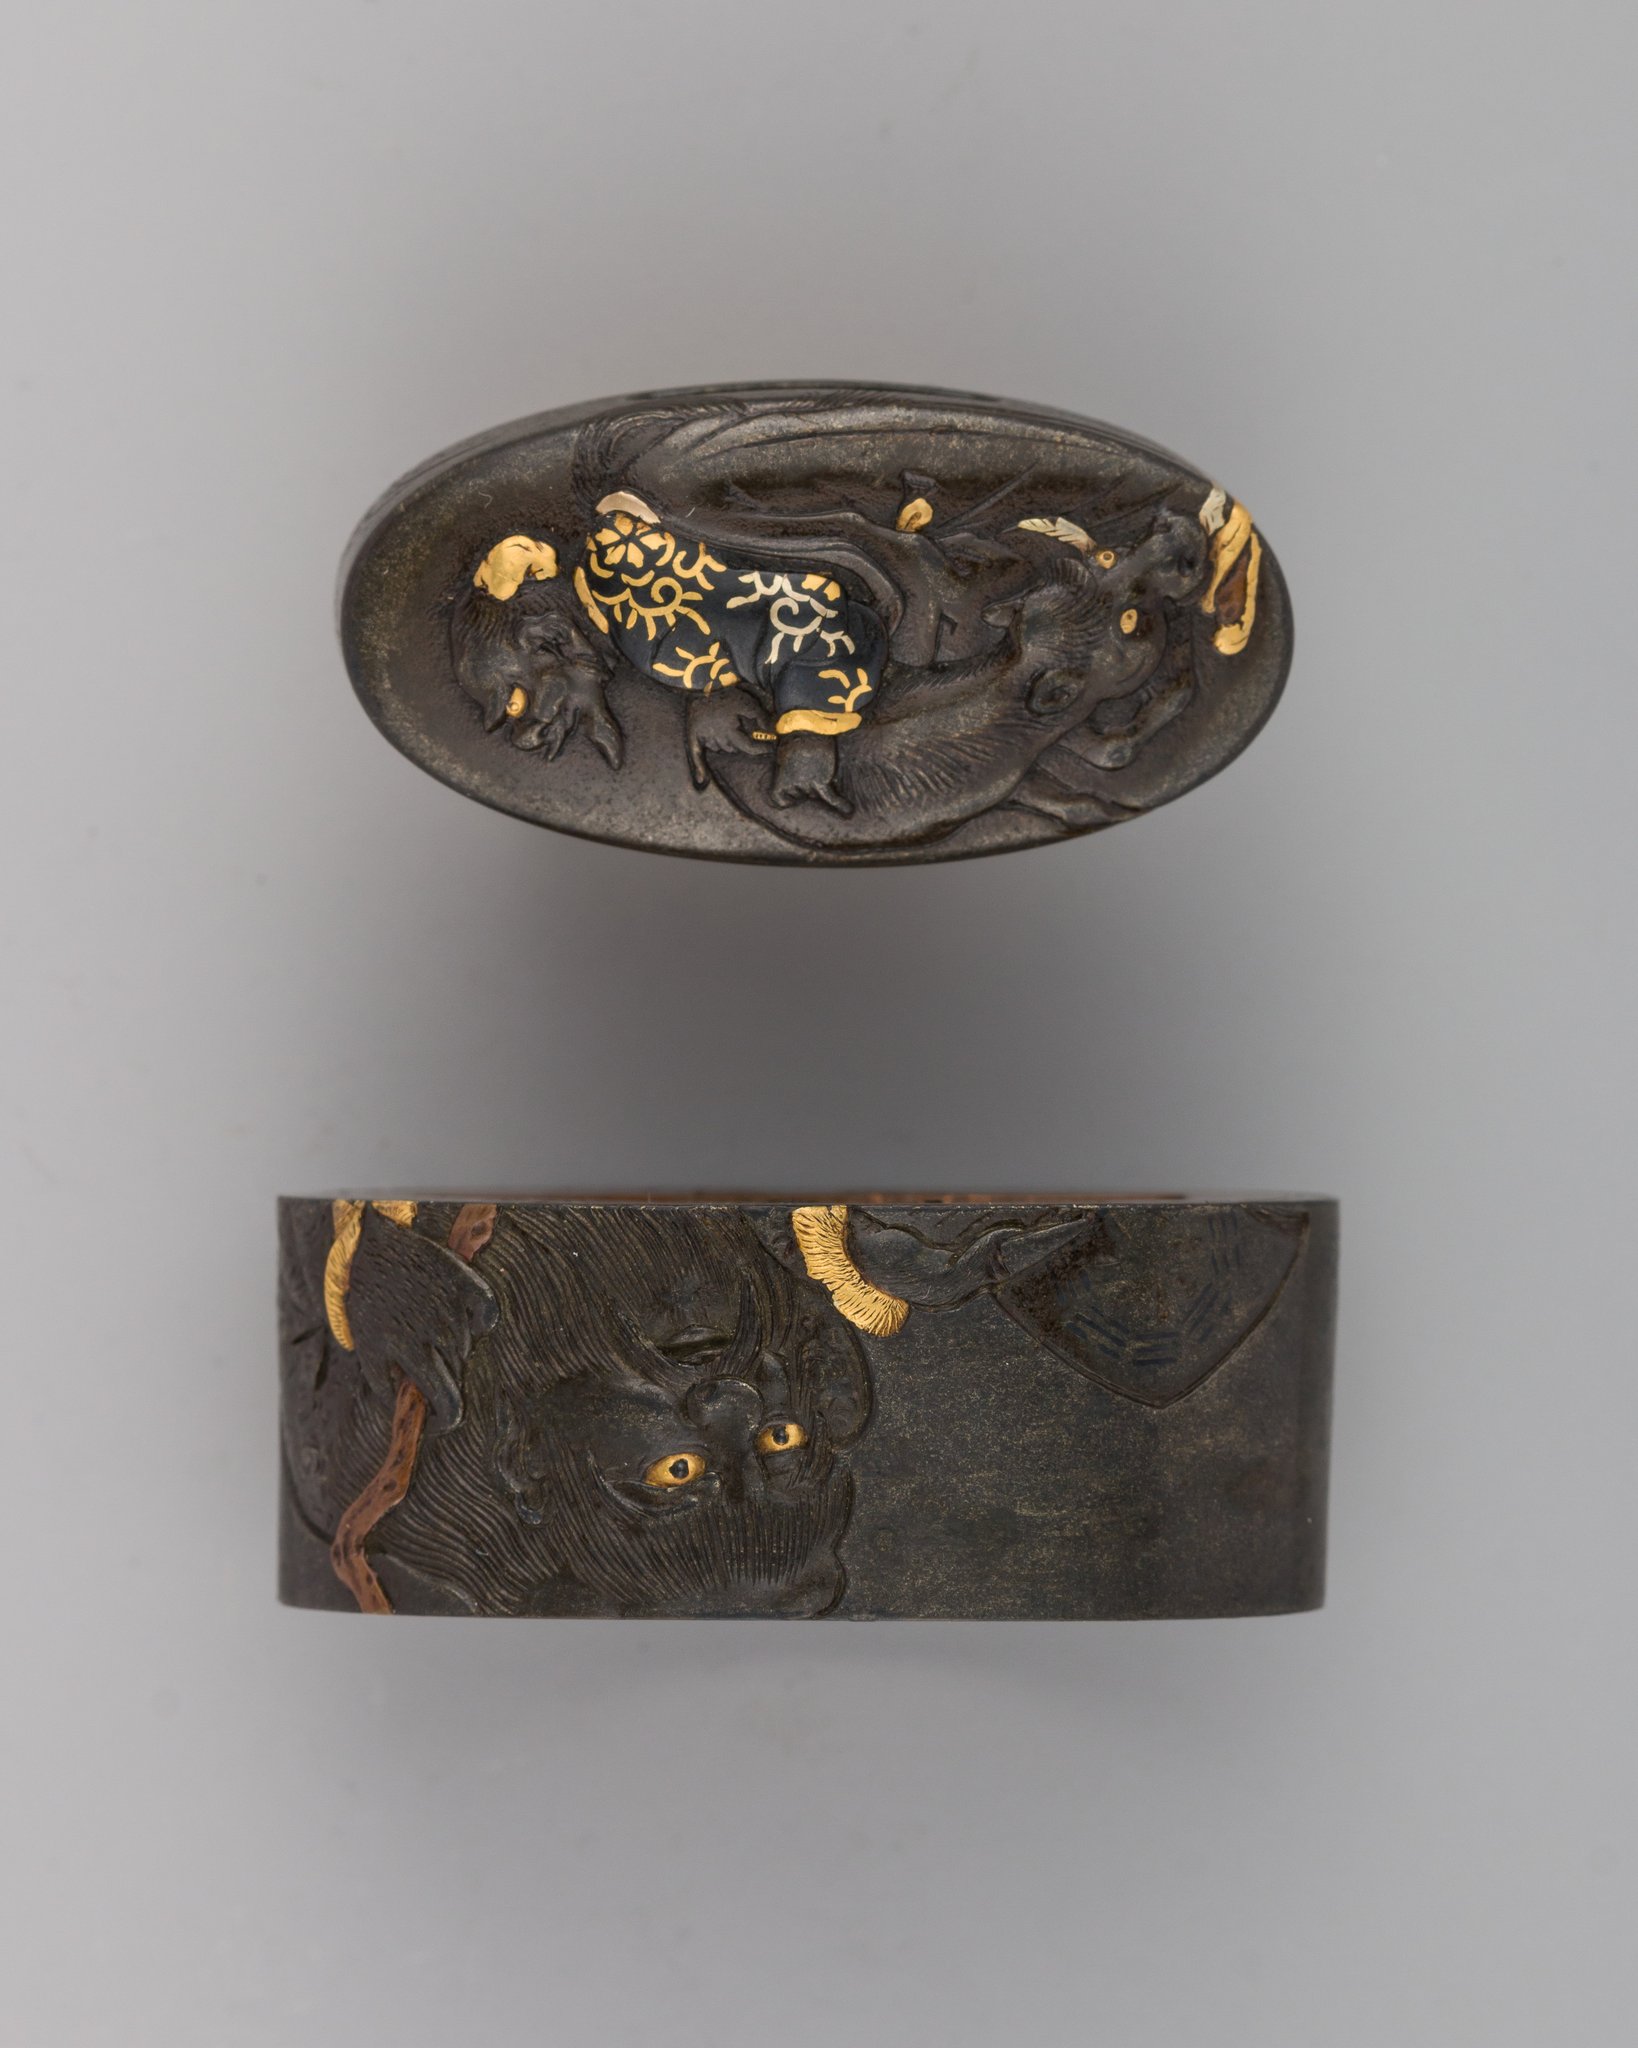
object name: sword hilt collar and pommel fuchigashira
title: Sword-Hilt Collar and Pommel (Fuchigashira)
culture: japanese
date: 1615-1868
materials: silver alloy, gold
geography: japan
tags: animals